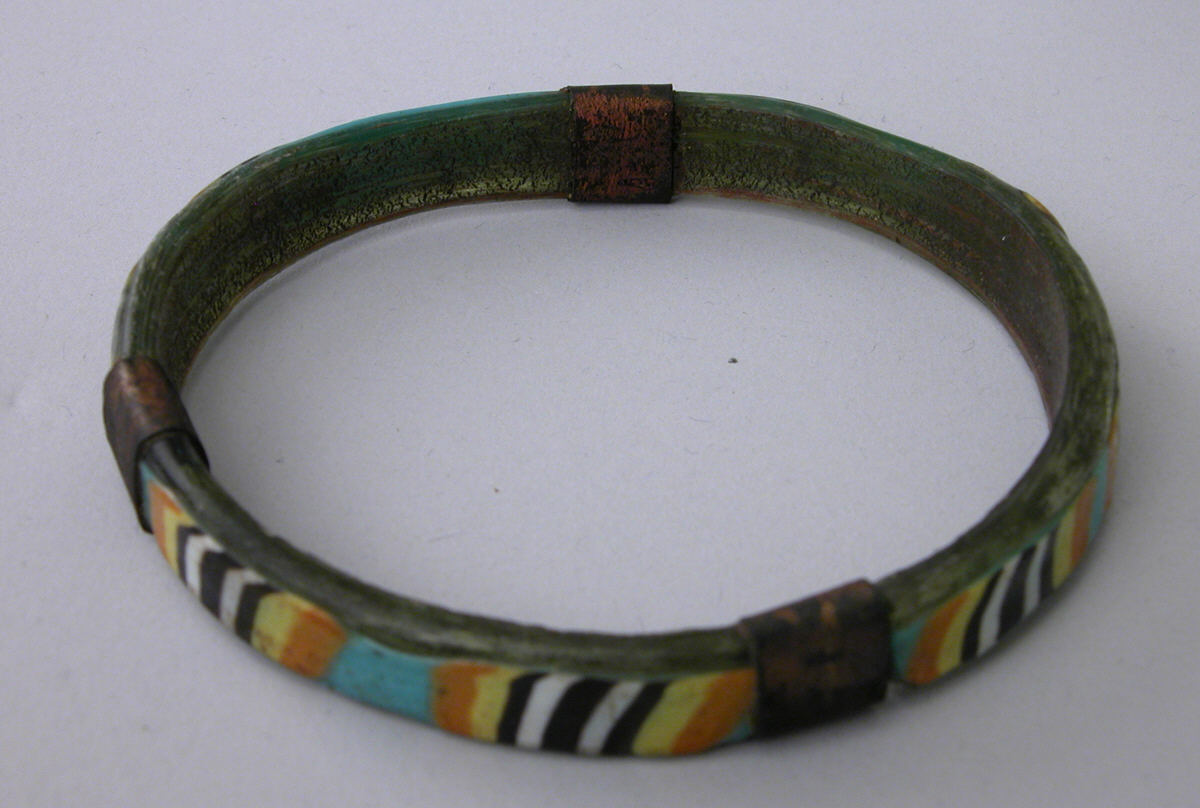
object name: bracelet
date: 1301-1500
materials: glass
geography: egypt or syria